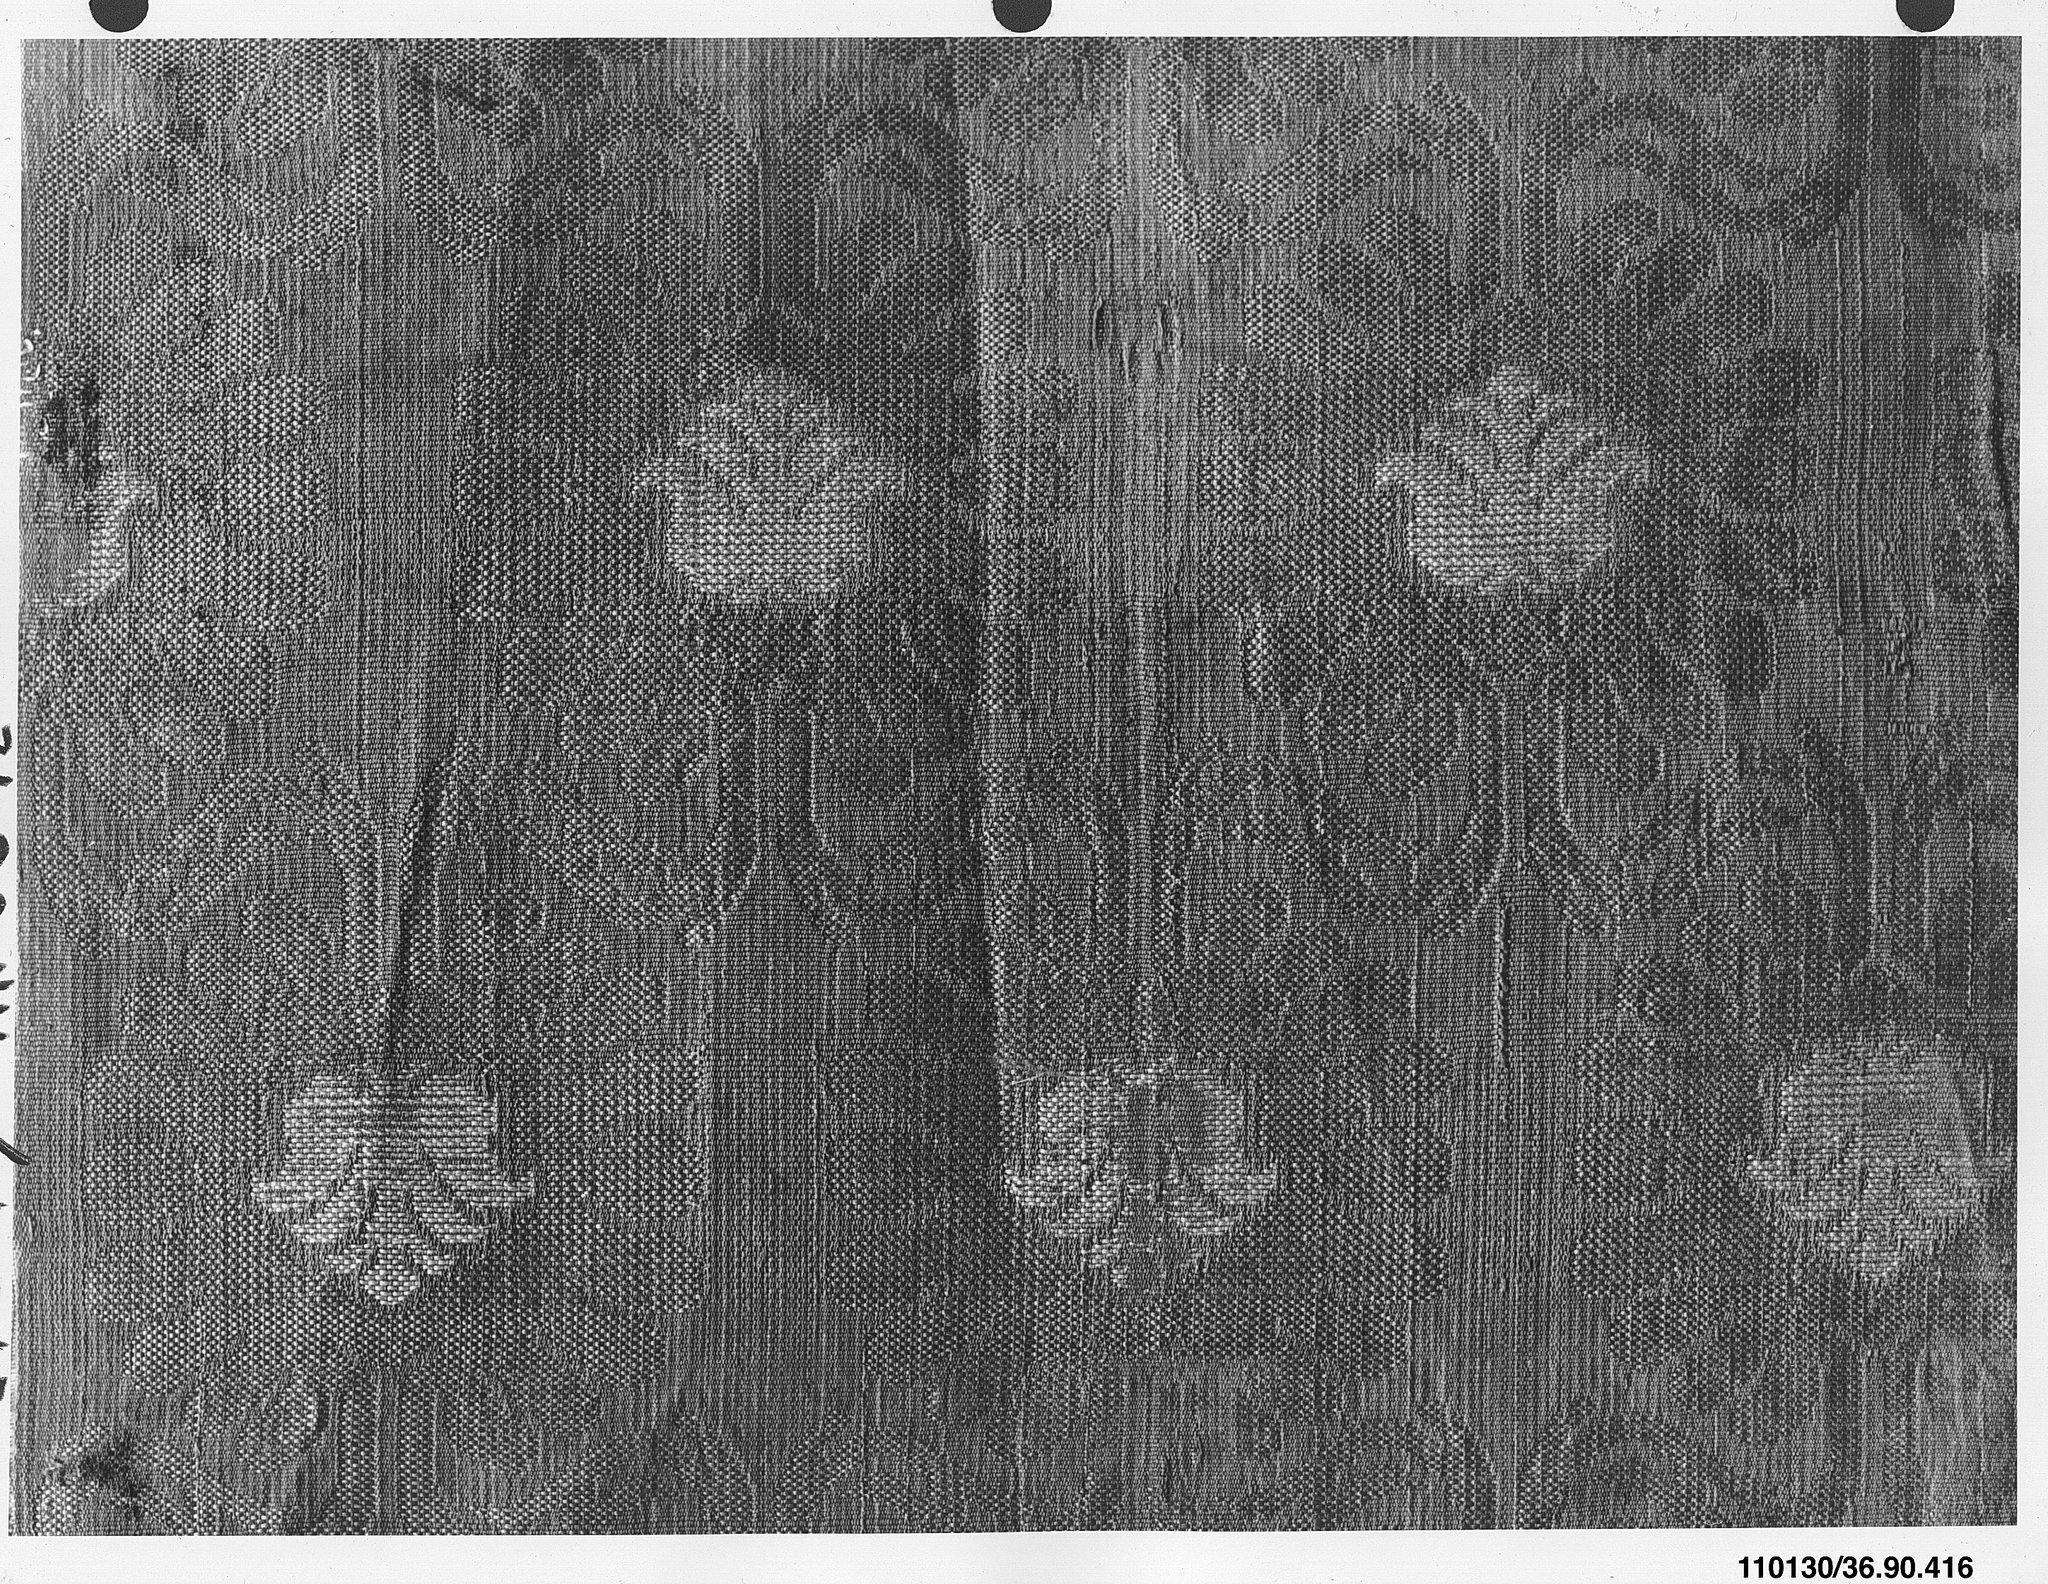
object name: piece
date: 1625-1650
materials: metal thread, silk